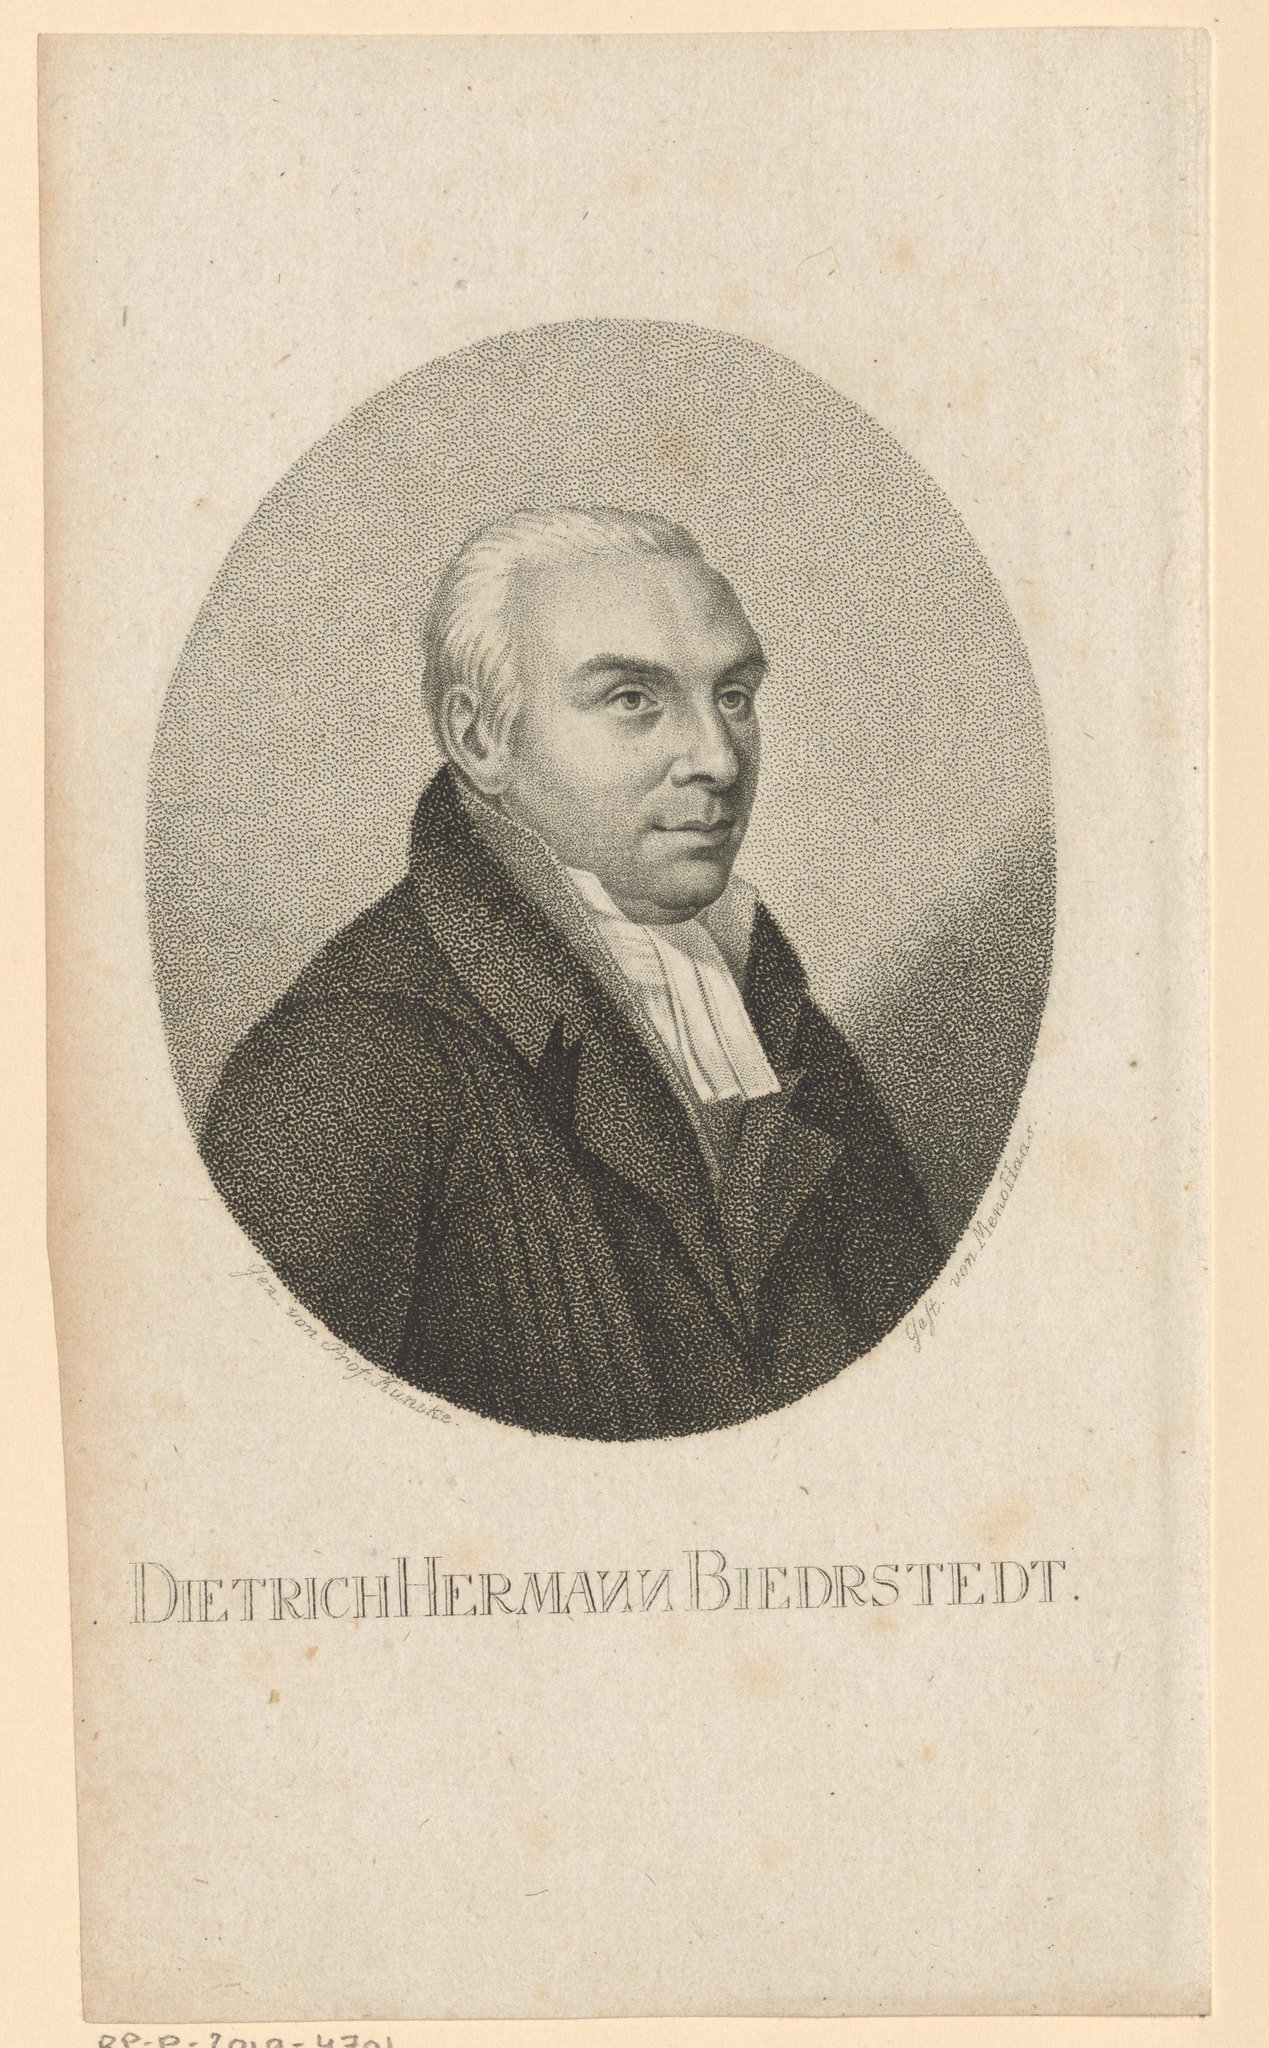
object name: print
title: Portret van Diederich Hermann Biederstedt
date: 1787-1833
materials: paper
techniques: etching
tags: theologian, historical persons